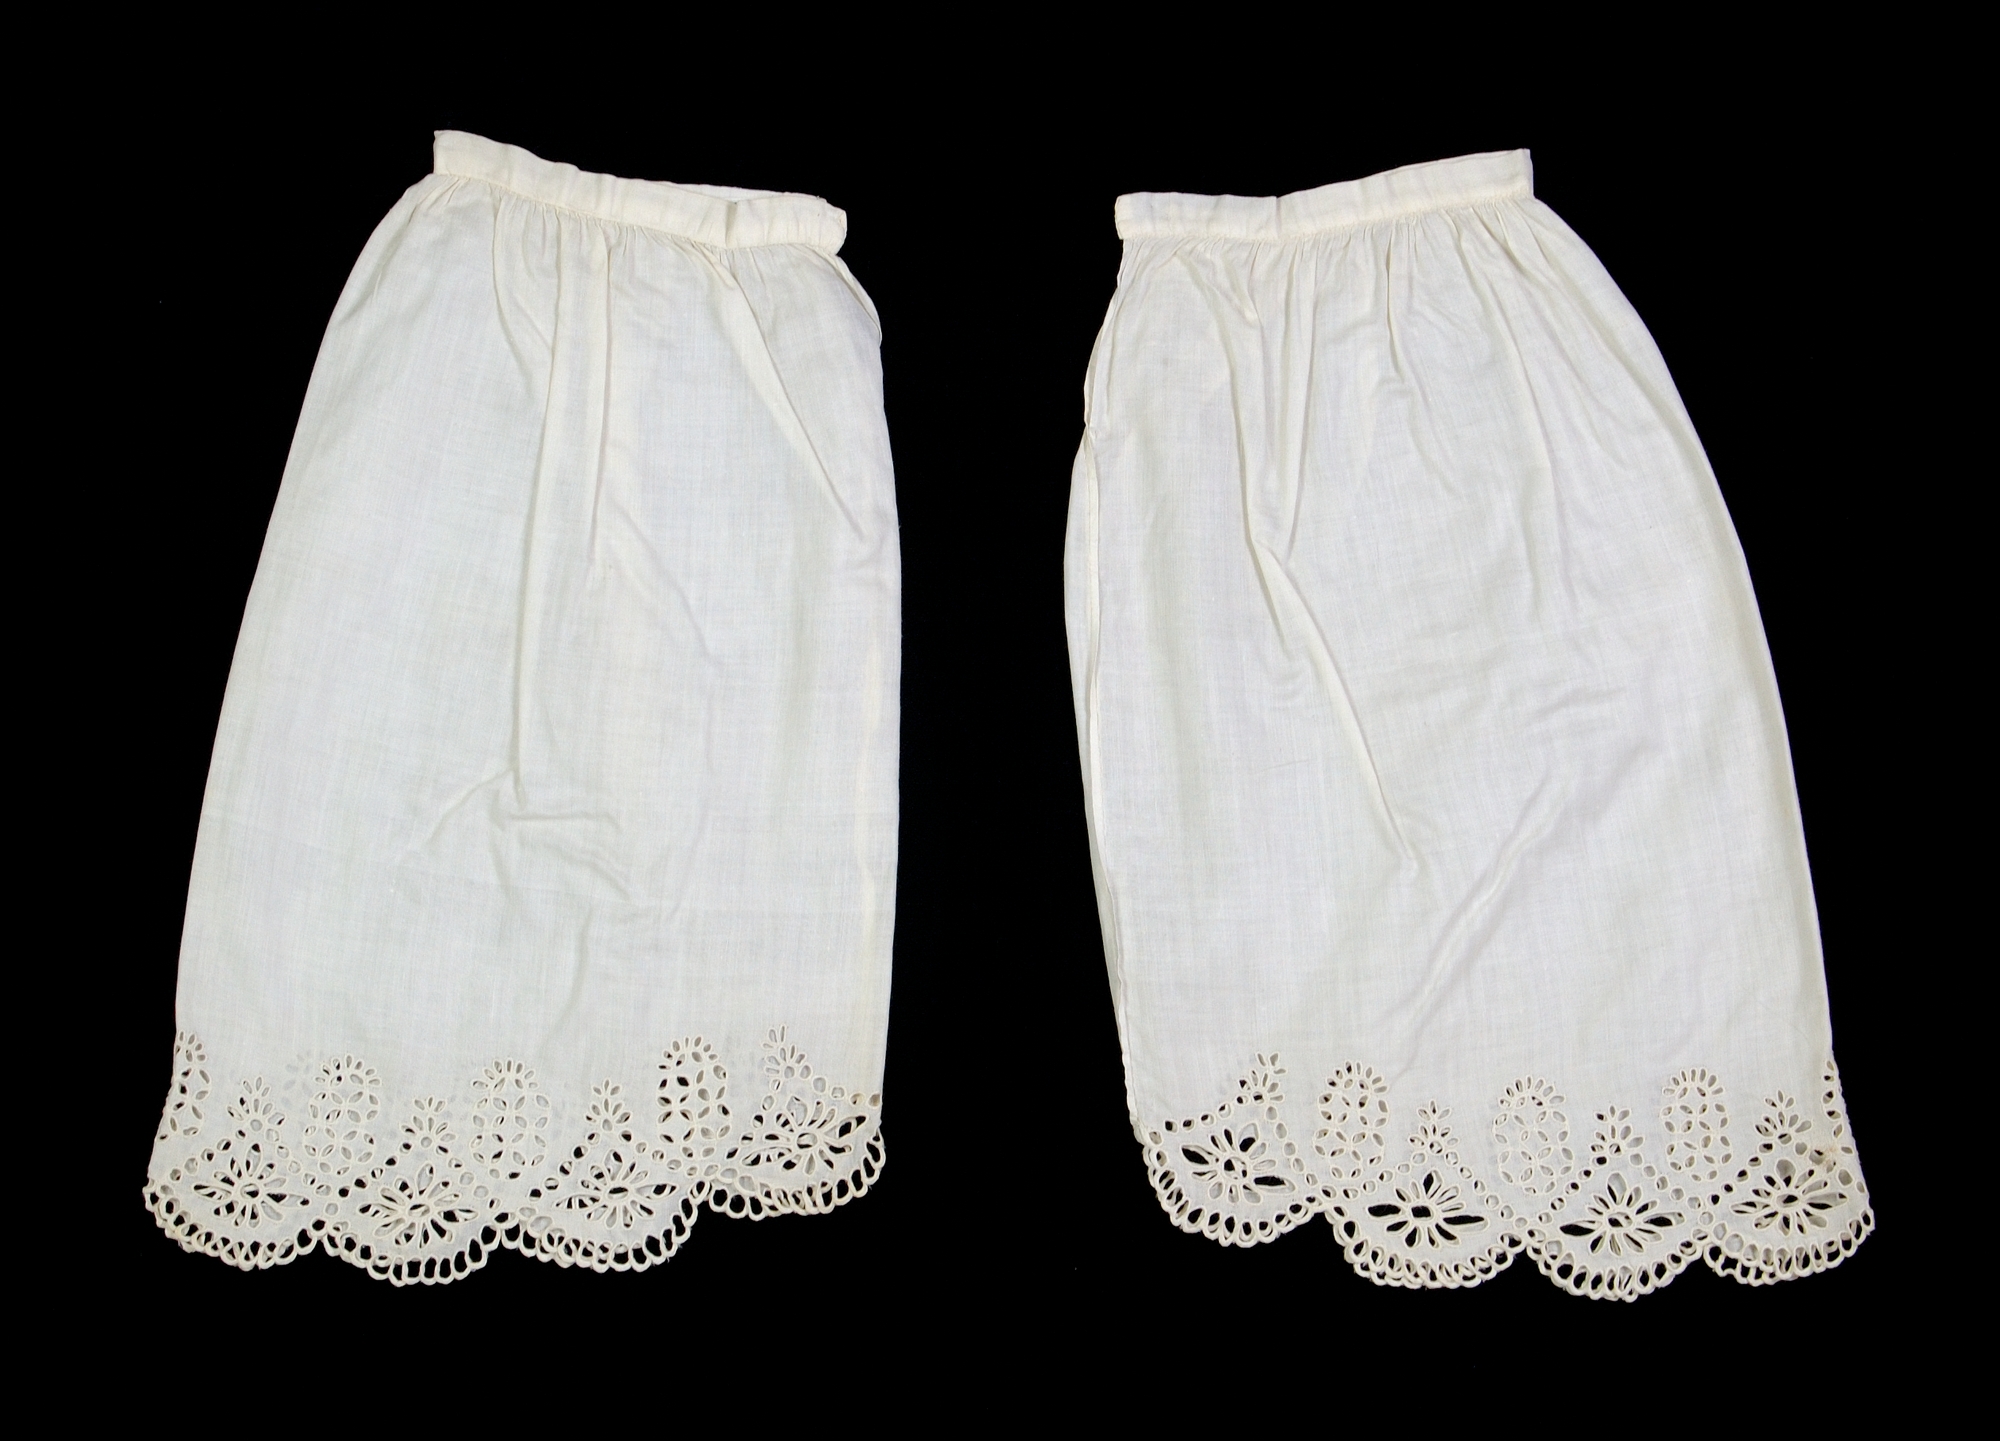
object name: undersleeves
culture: american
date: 1860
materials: cotton